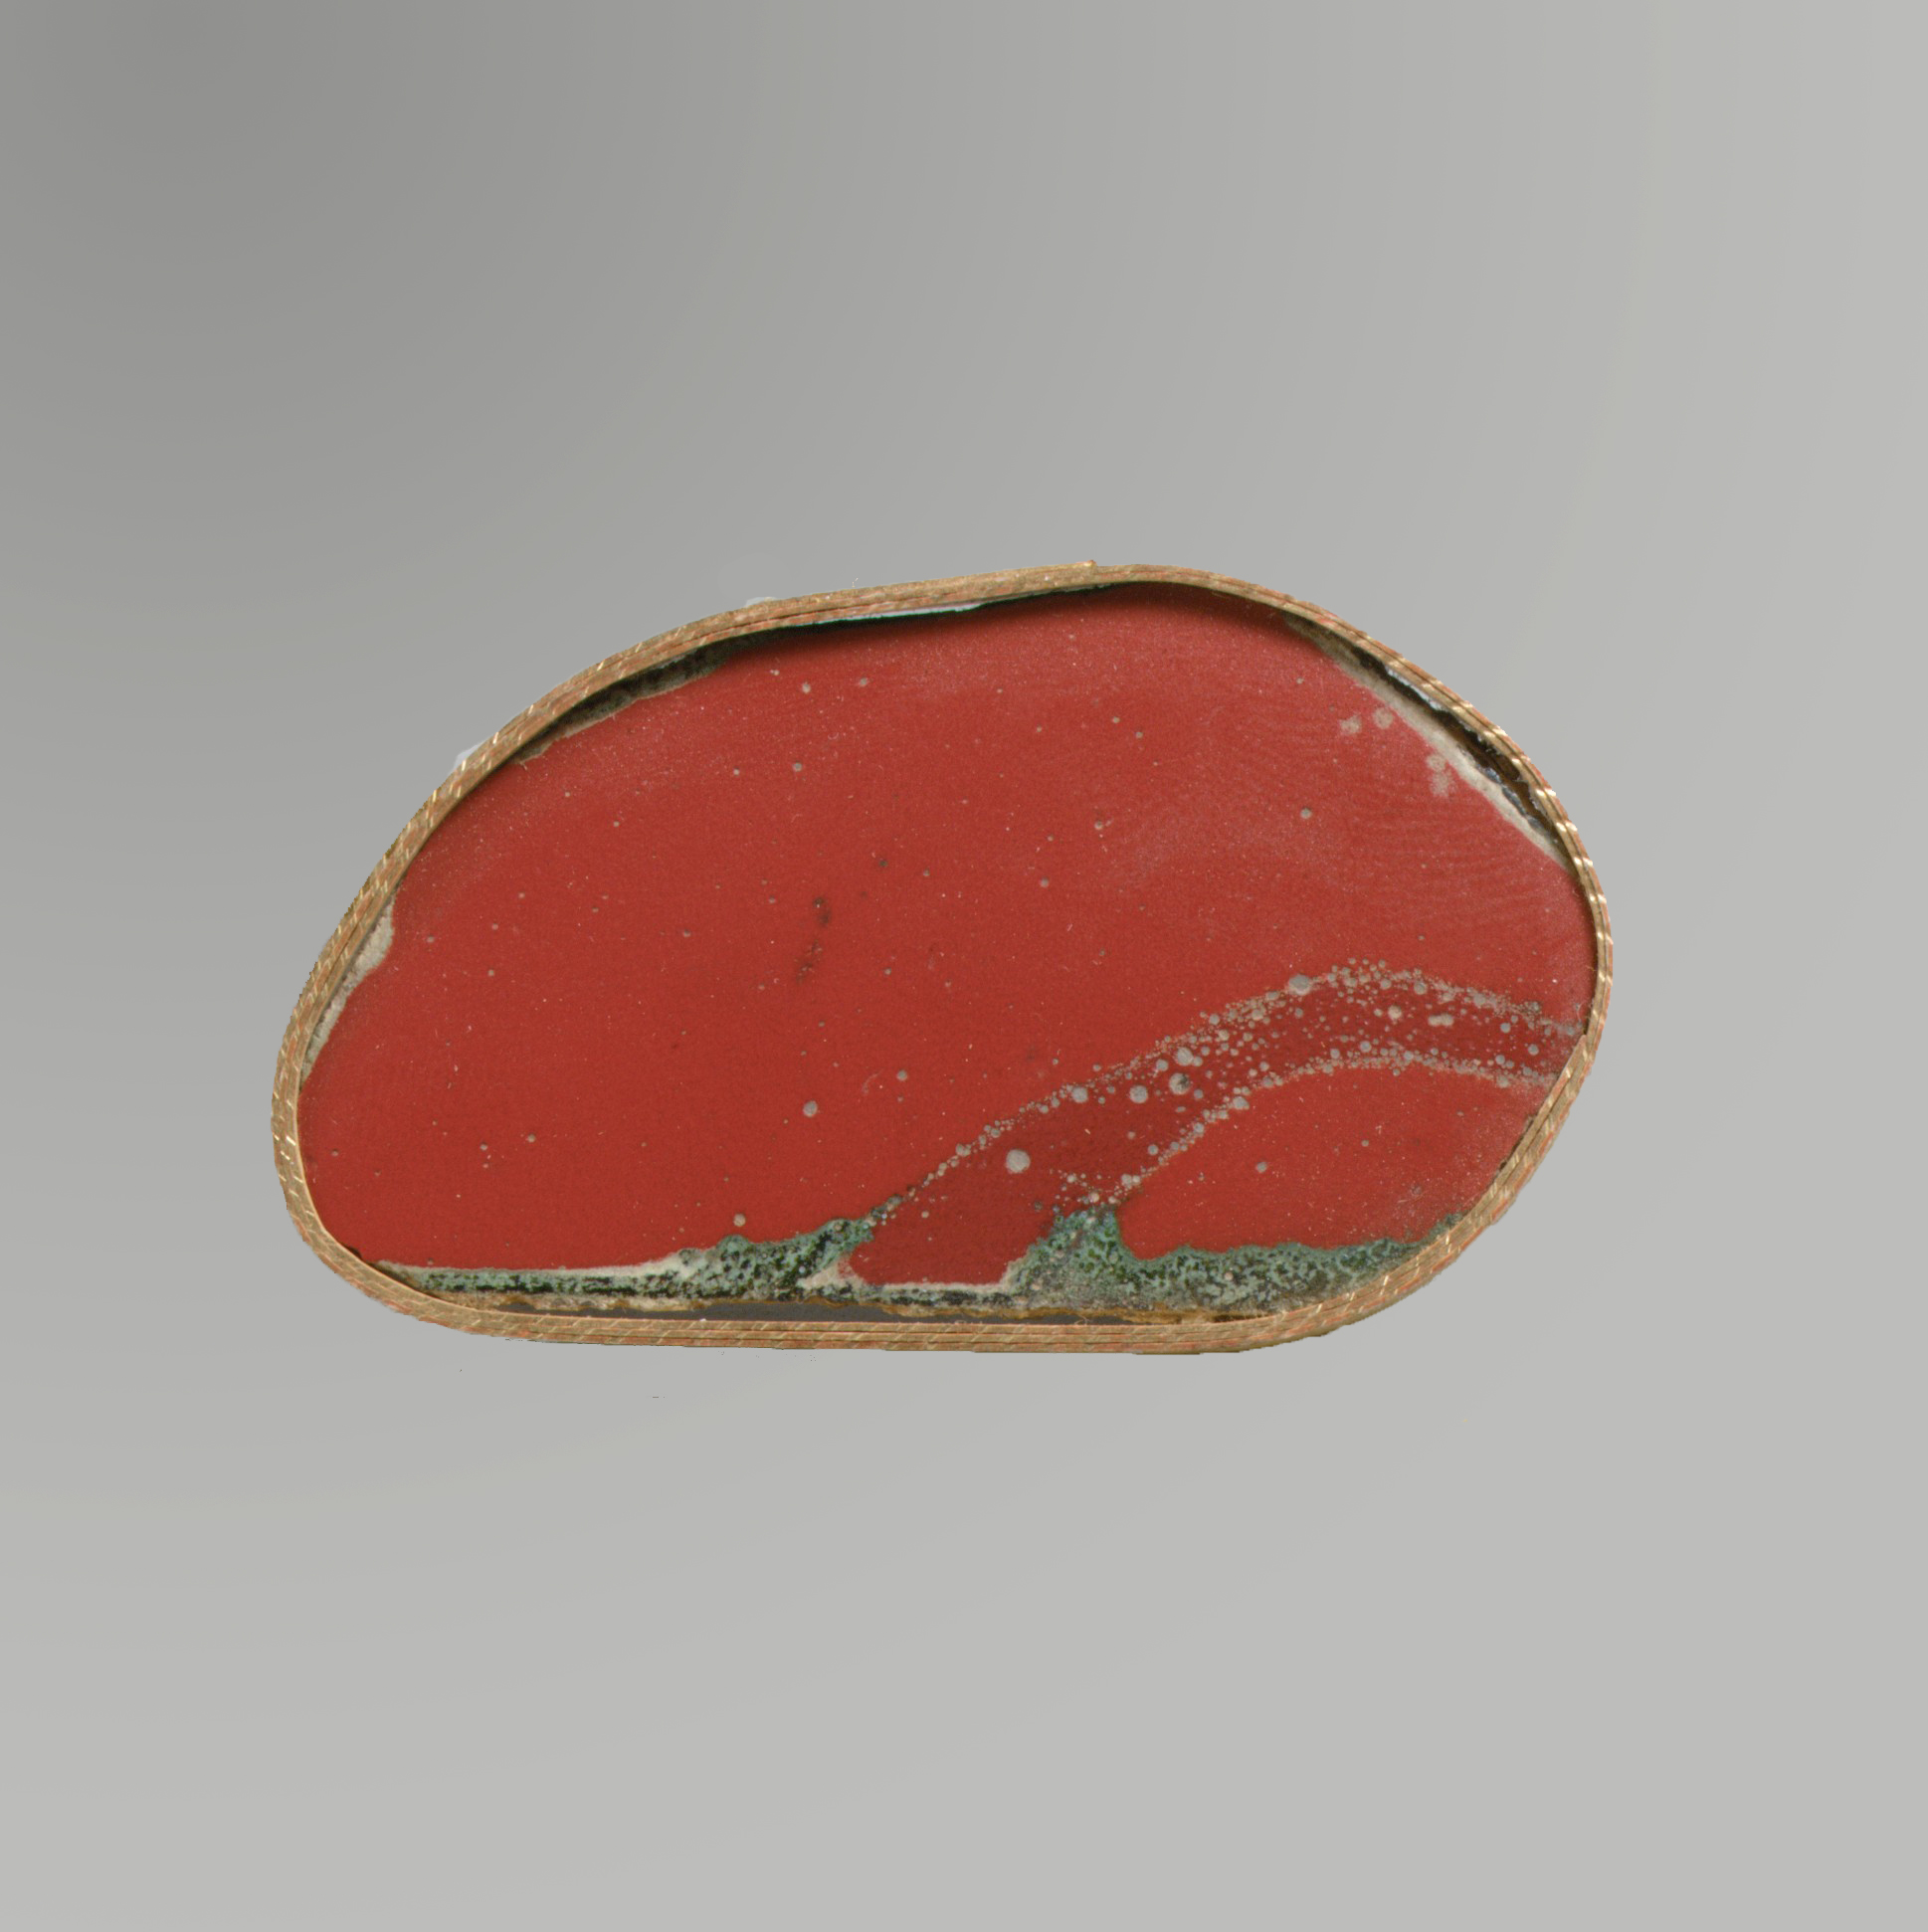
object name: fragment, monochrome, opaque red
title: Glass monochrome inlay fragment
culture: roman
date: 1-50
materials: glass